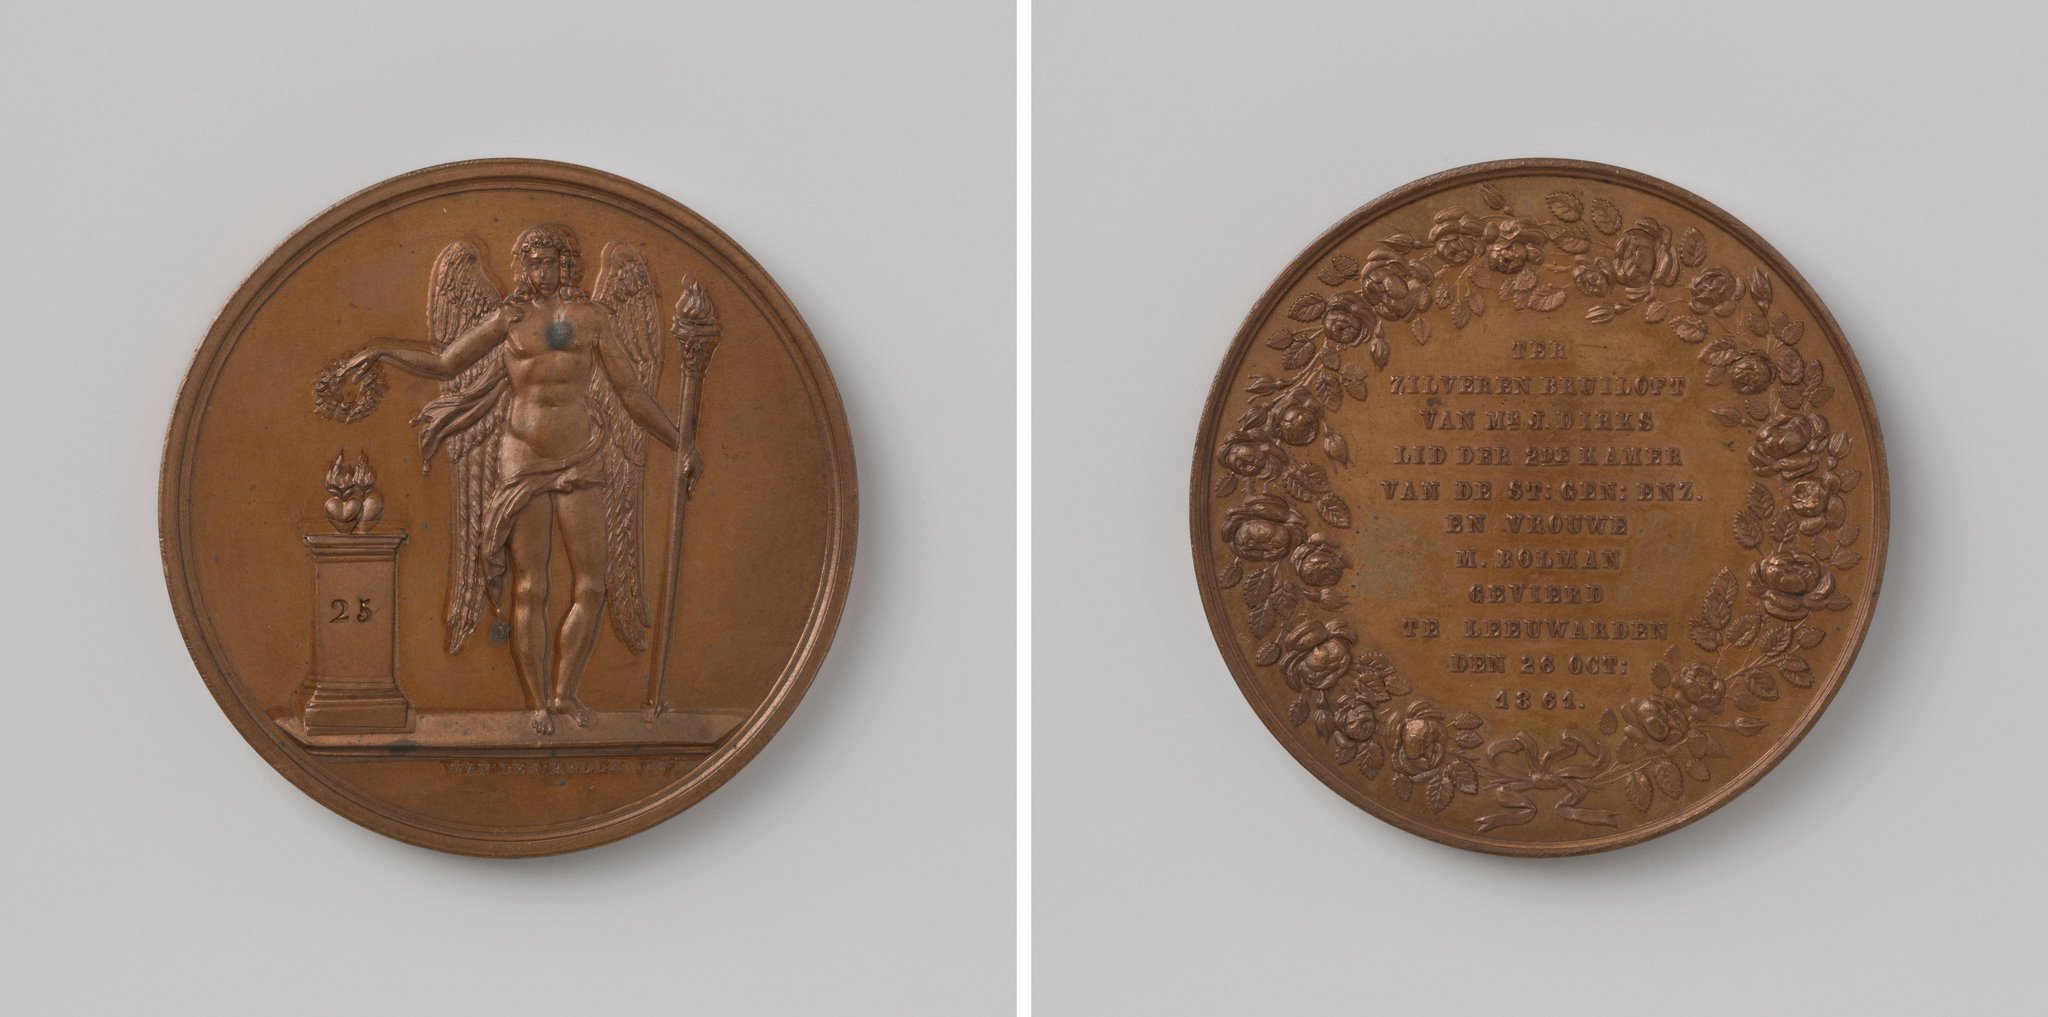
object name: family medal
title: Vijfentwintigjarig huwelijk van Jacob Dirks, lid van de Tweede Kamer en Minschje Bolman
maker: david van der kellen (1804-1879)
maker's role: die cutter, draughtsman, print maker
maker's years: 1804-1879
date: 1861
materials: bronze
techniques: engraving, striking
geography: utrecht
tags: politician